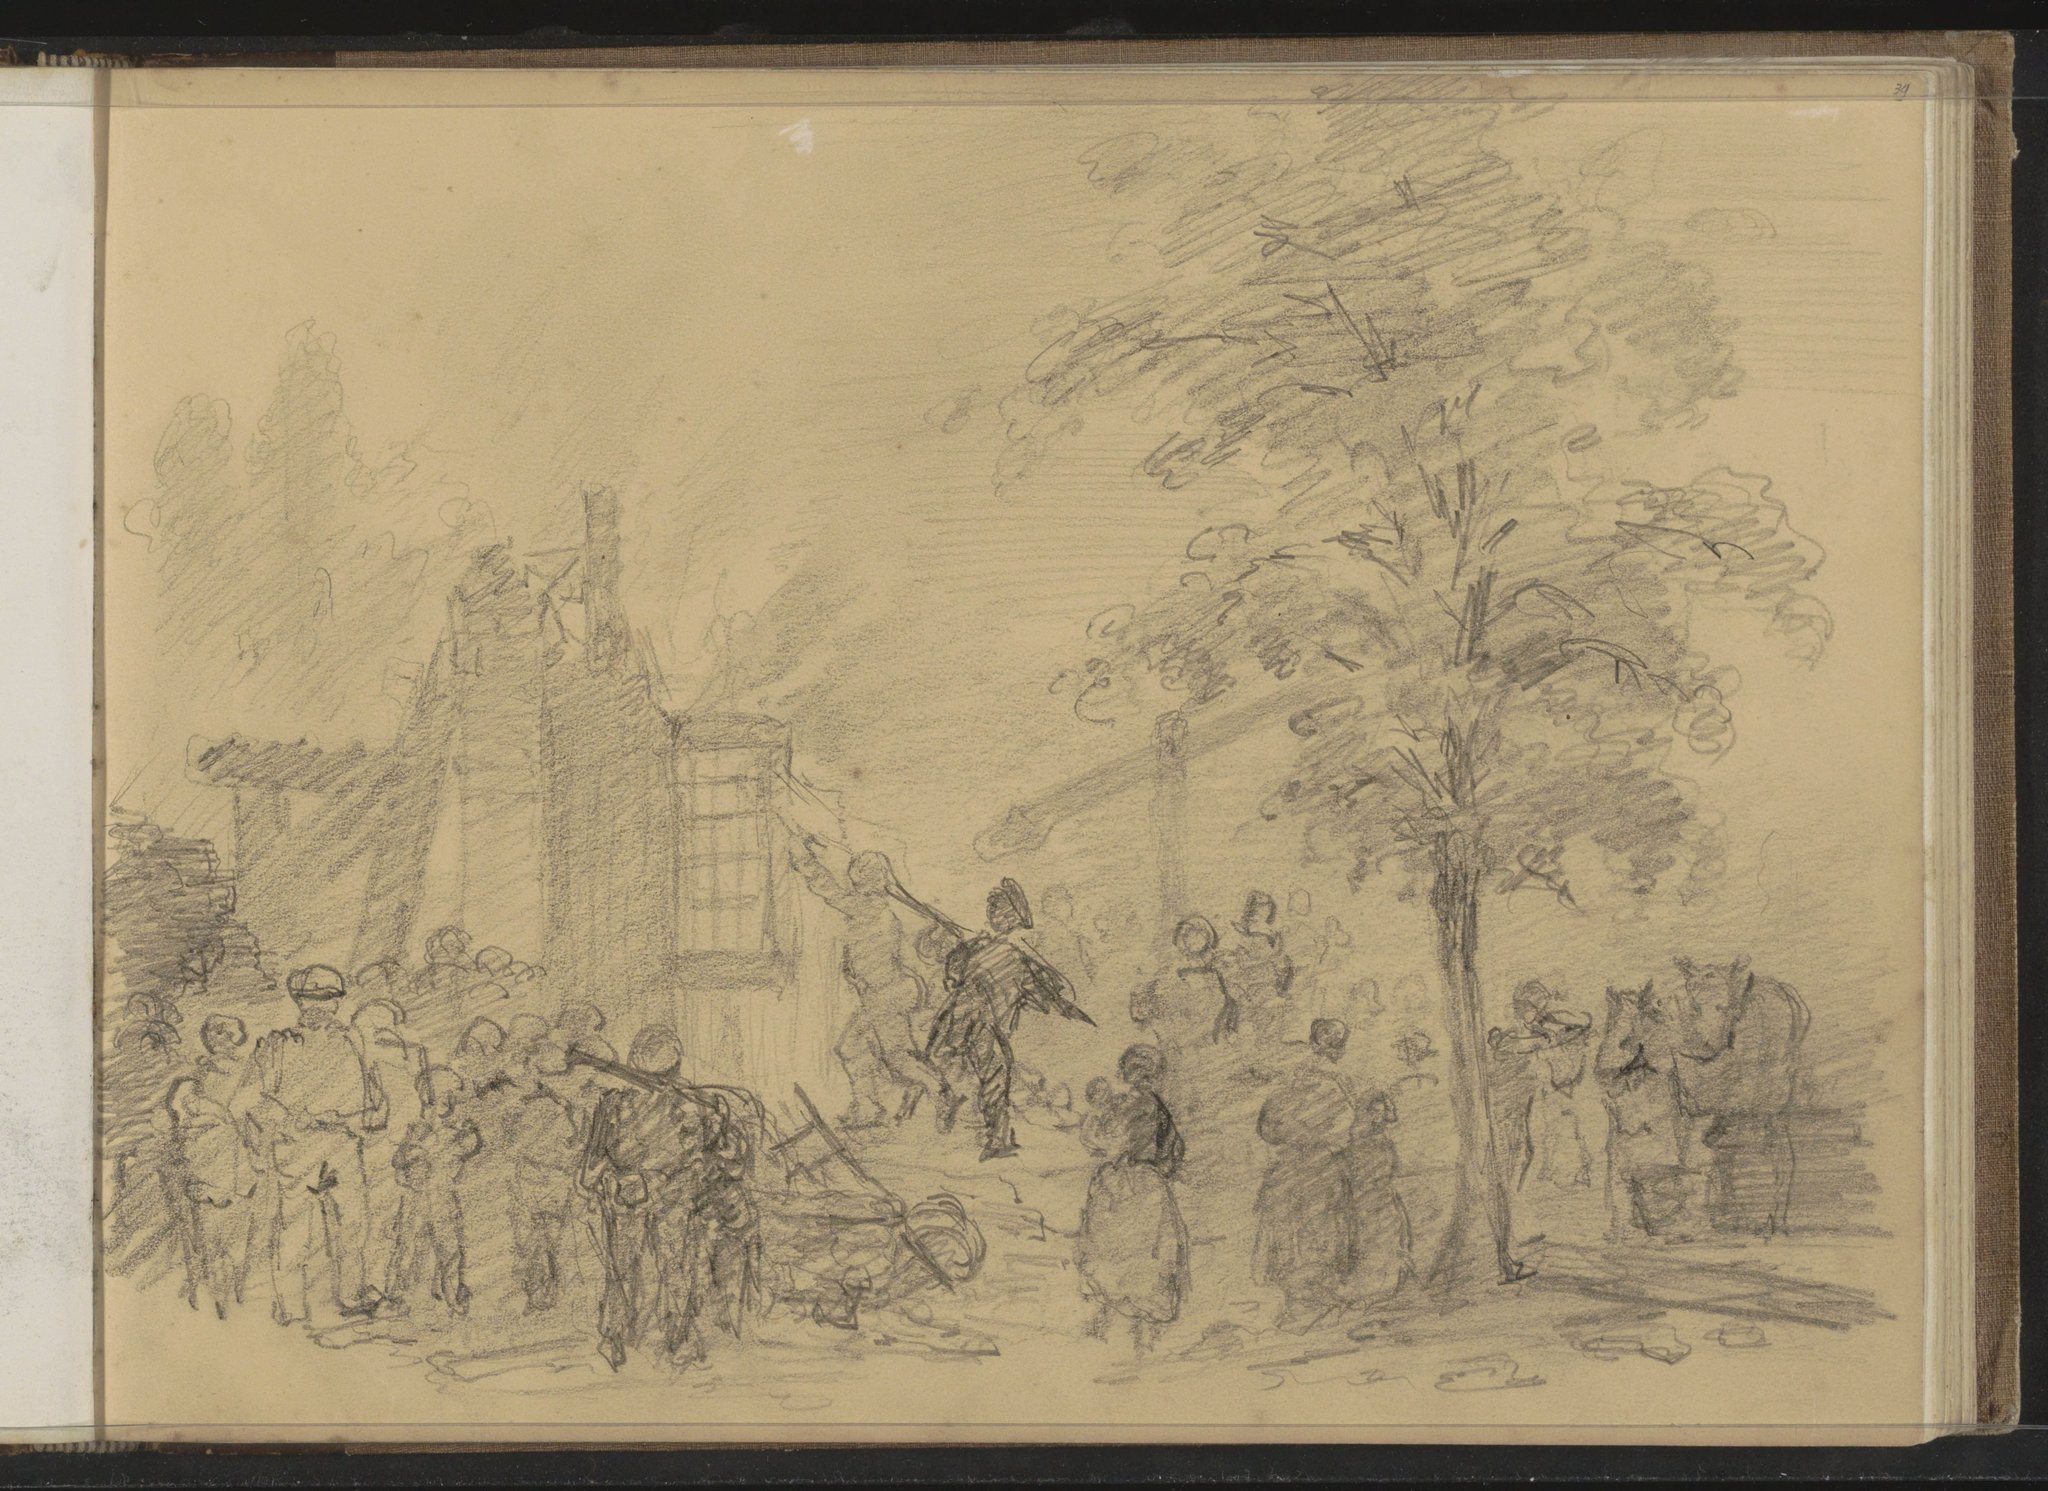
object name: sketchbook leaf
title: Groep figuren rondom een gebouw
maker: hendrik valkenburg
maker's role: draughtsman, painter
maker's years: 1826-1896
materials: paper, pencil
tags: village street (+ city(-scape) with figures, staffage)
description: Een groep figuren kijkt toe hoe twee mannen op een gebouw afrennen. Blad 39 recto uit een schetsboek met 77 bladen.